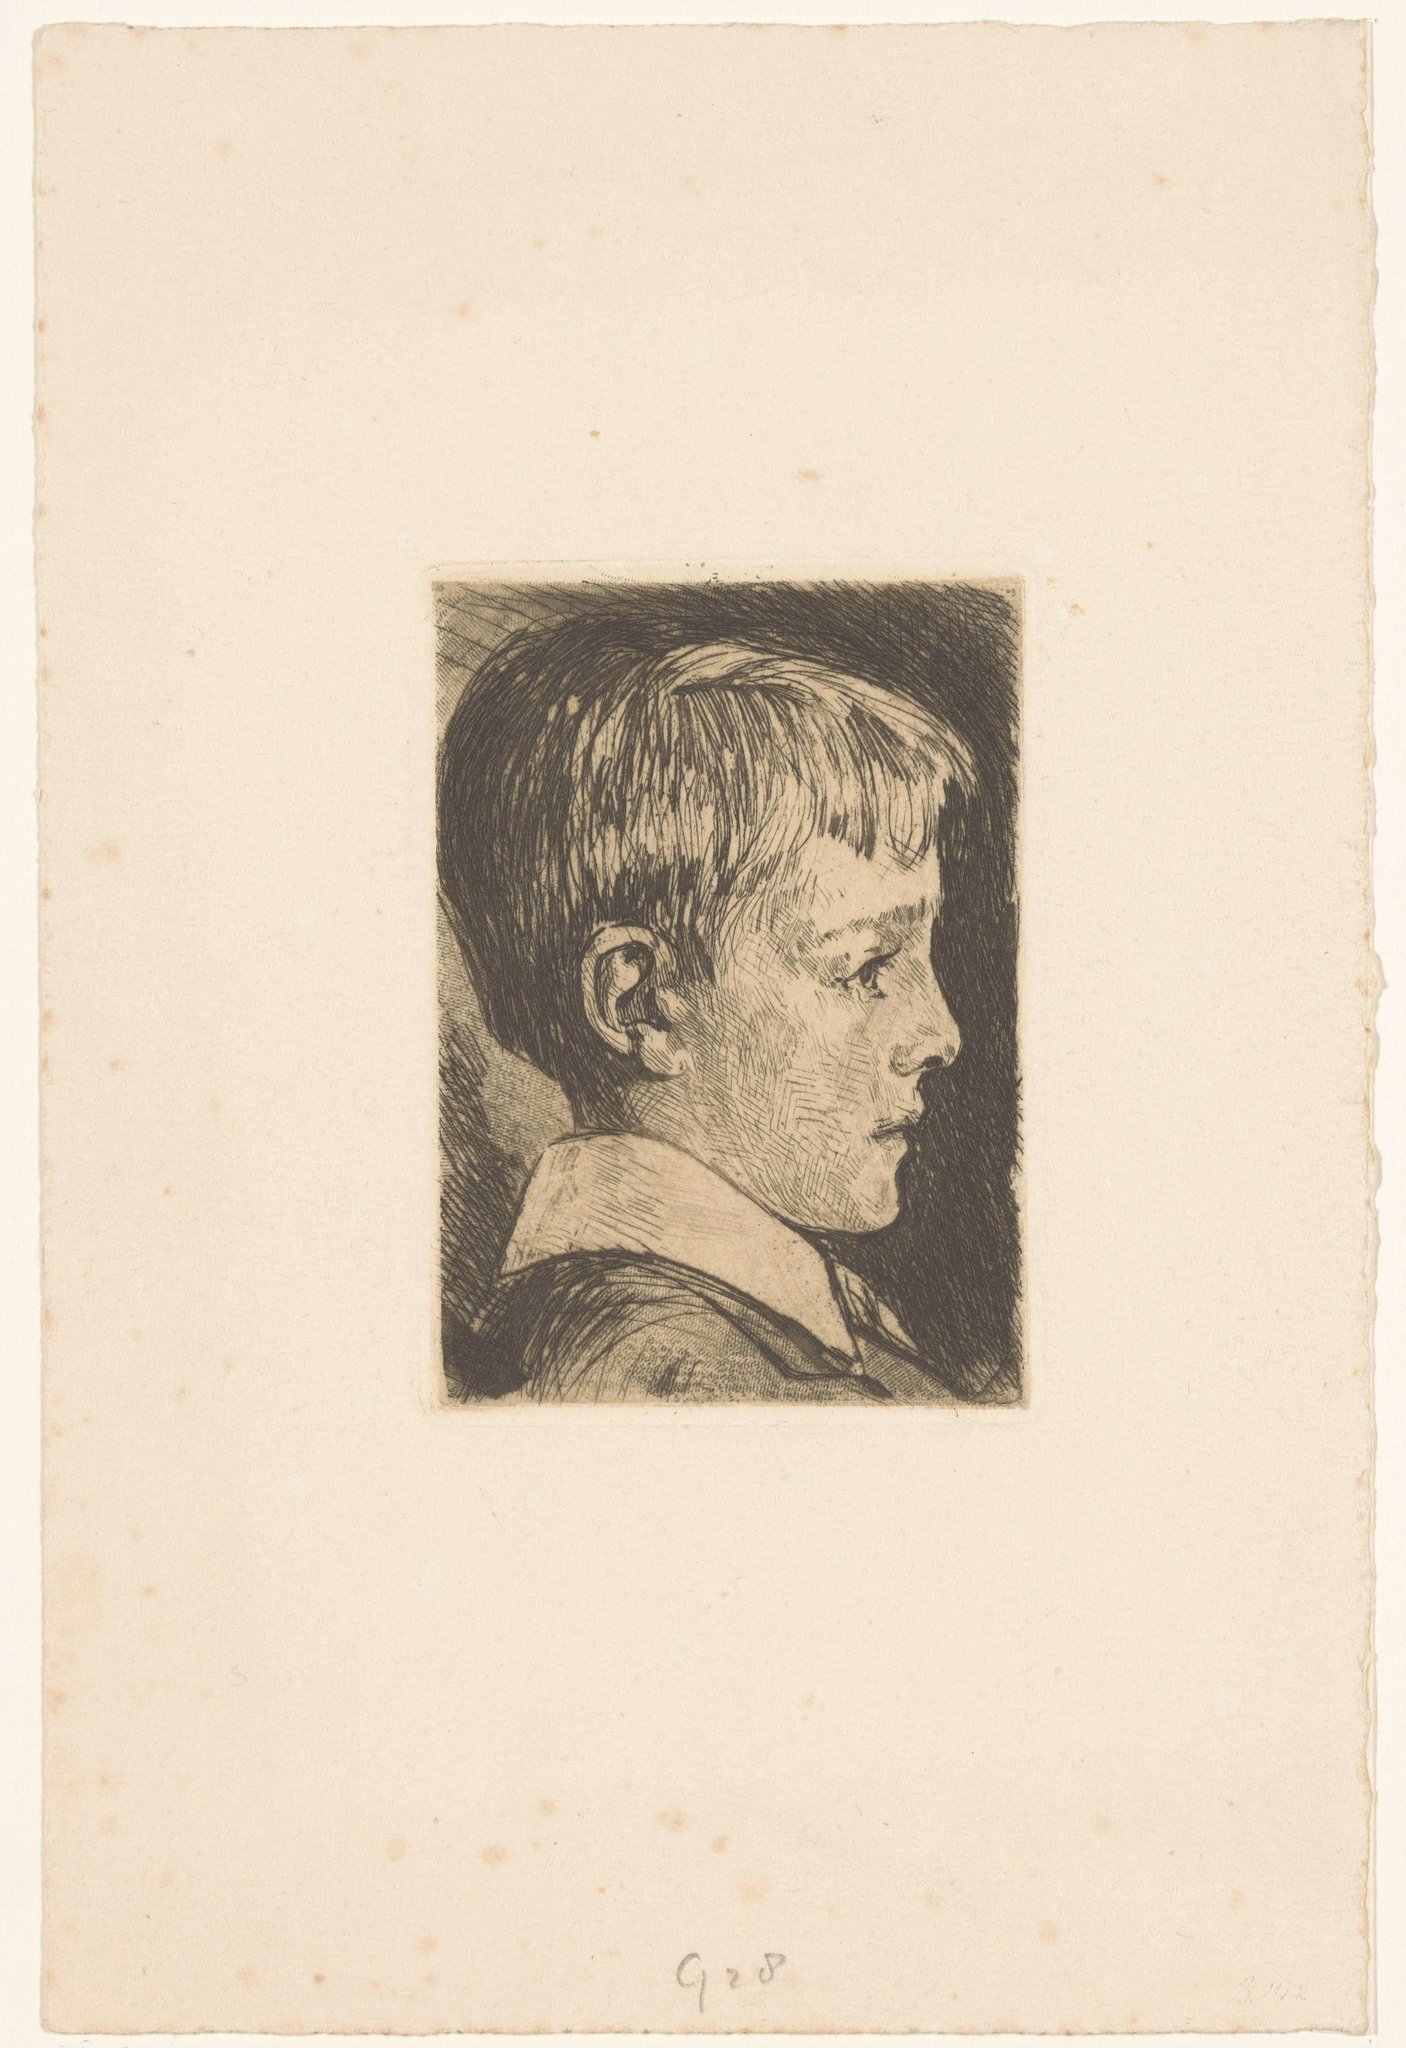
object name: print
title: Portret van Wouter Nijhoff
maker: willem witsen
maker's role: draughtsman, painter, print maker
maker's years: 1860-1923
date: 1909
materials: paper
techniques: aquatint, etching, roulette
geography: amsterdam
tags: historical persons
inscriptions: watermark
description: Wouter Nijhoff was de zoon van Paul Nijhoff, die sinds 1893 een van de directeuren van Scheltema & Holkema's Boekhandel was.